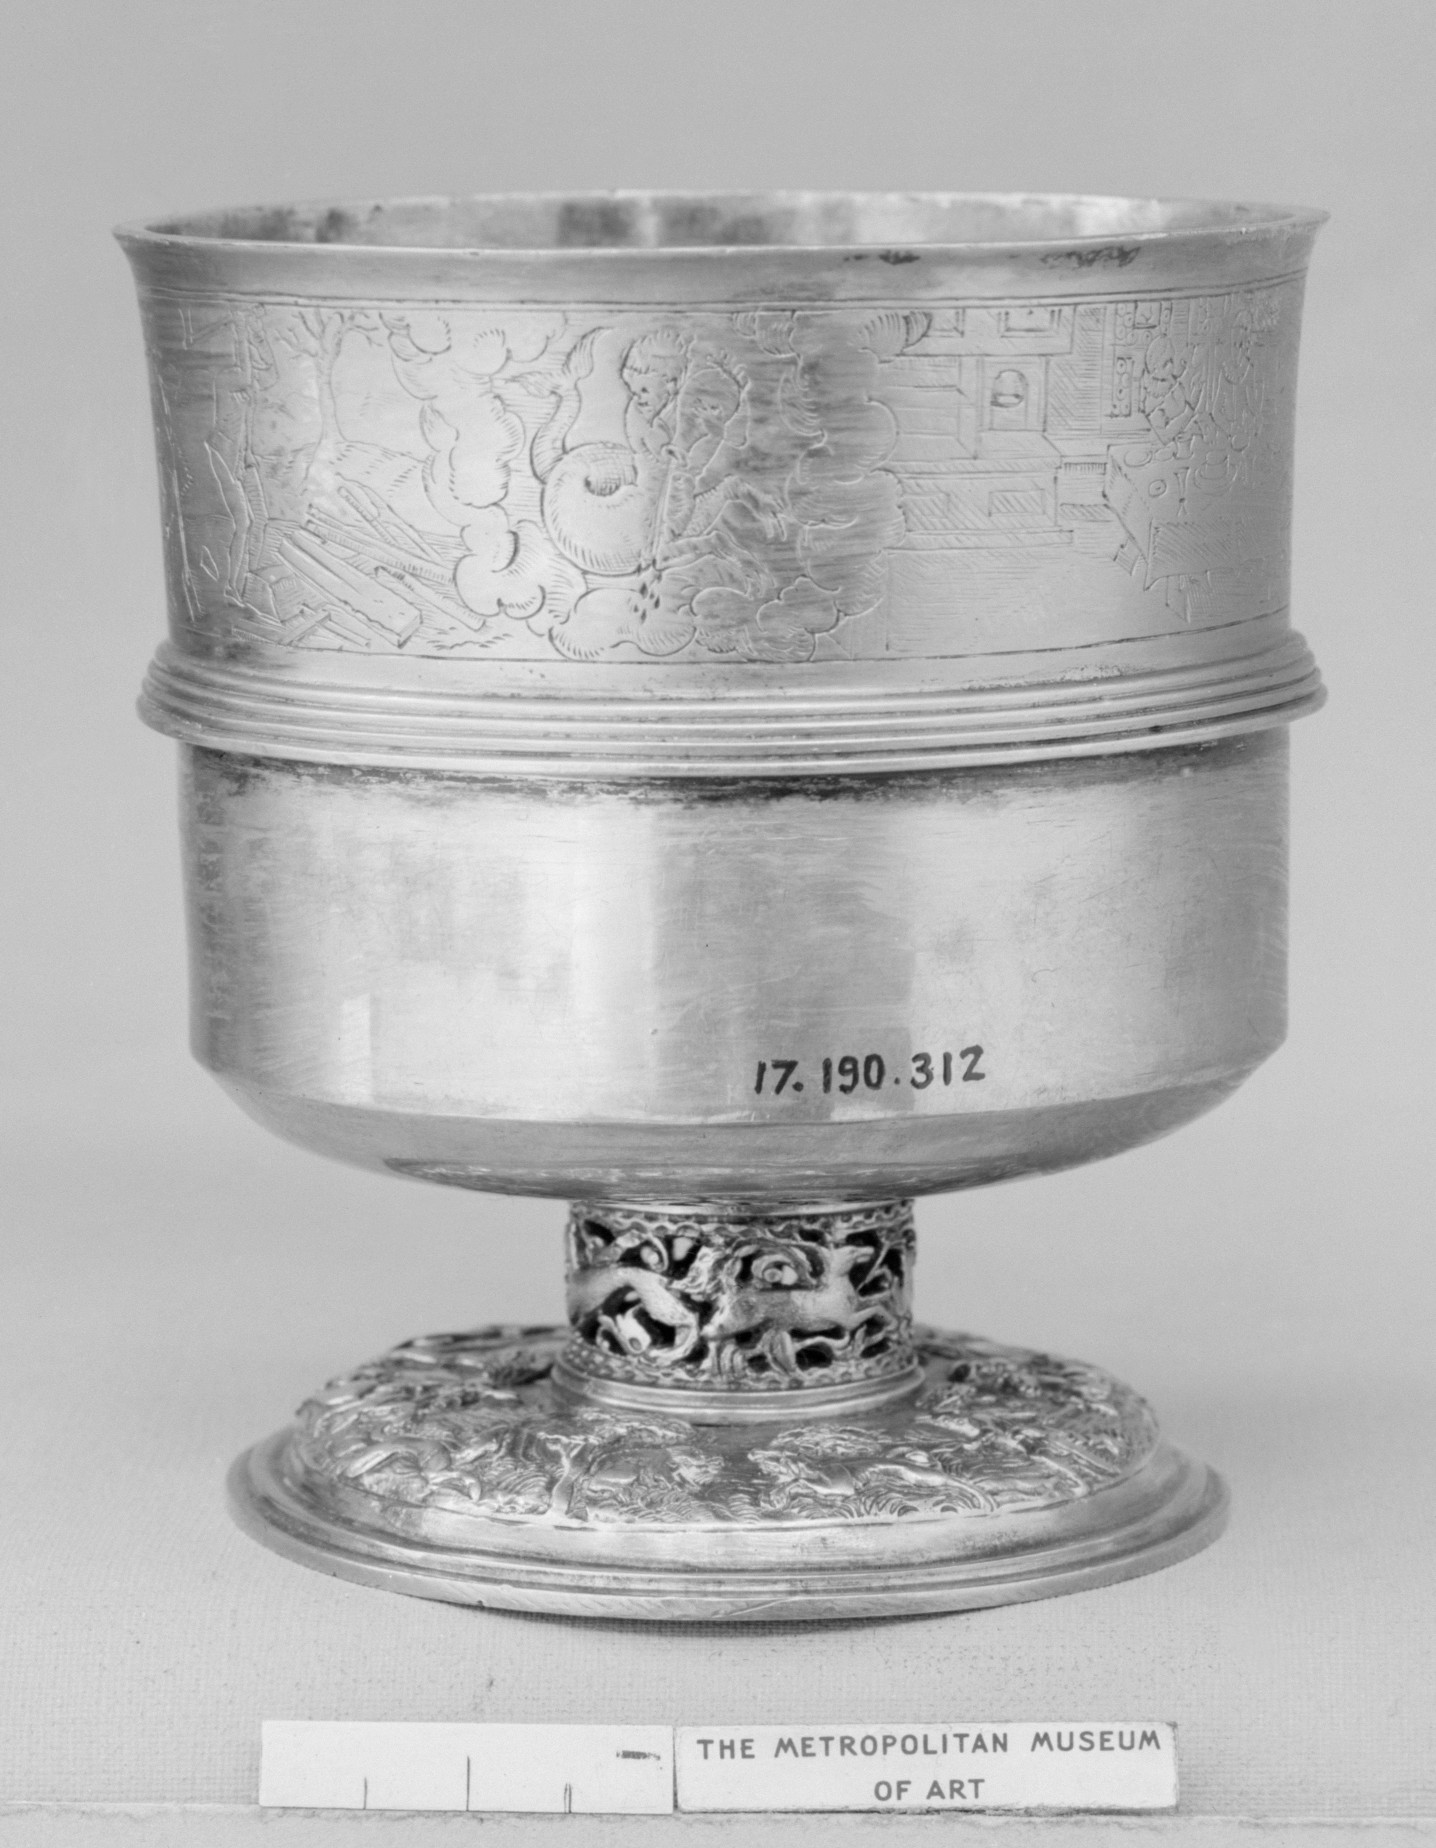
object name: cup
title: Cup (one of a set)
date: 1501-1600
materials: gilt, silver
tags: animals,men